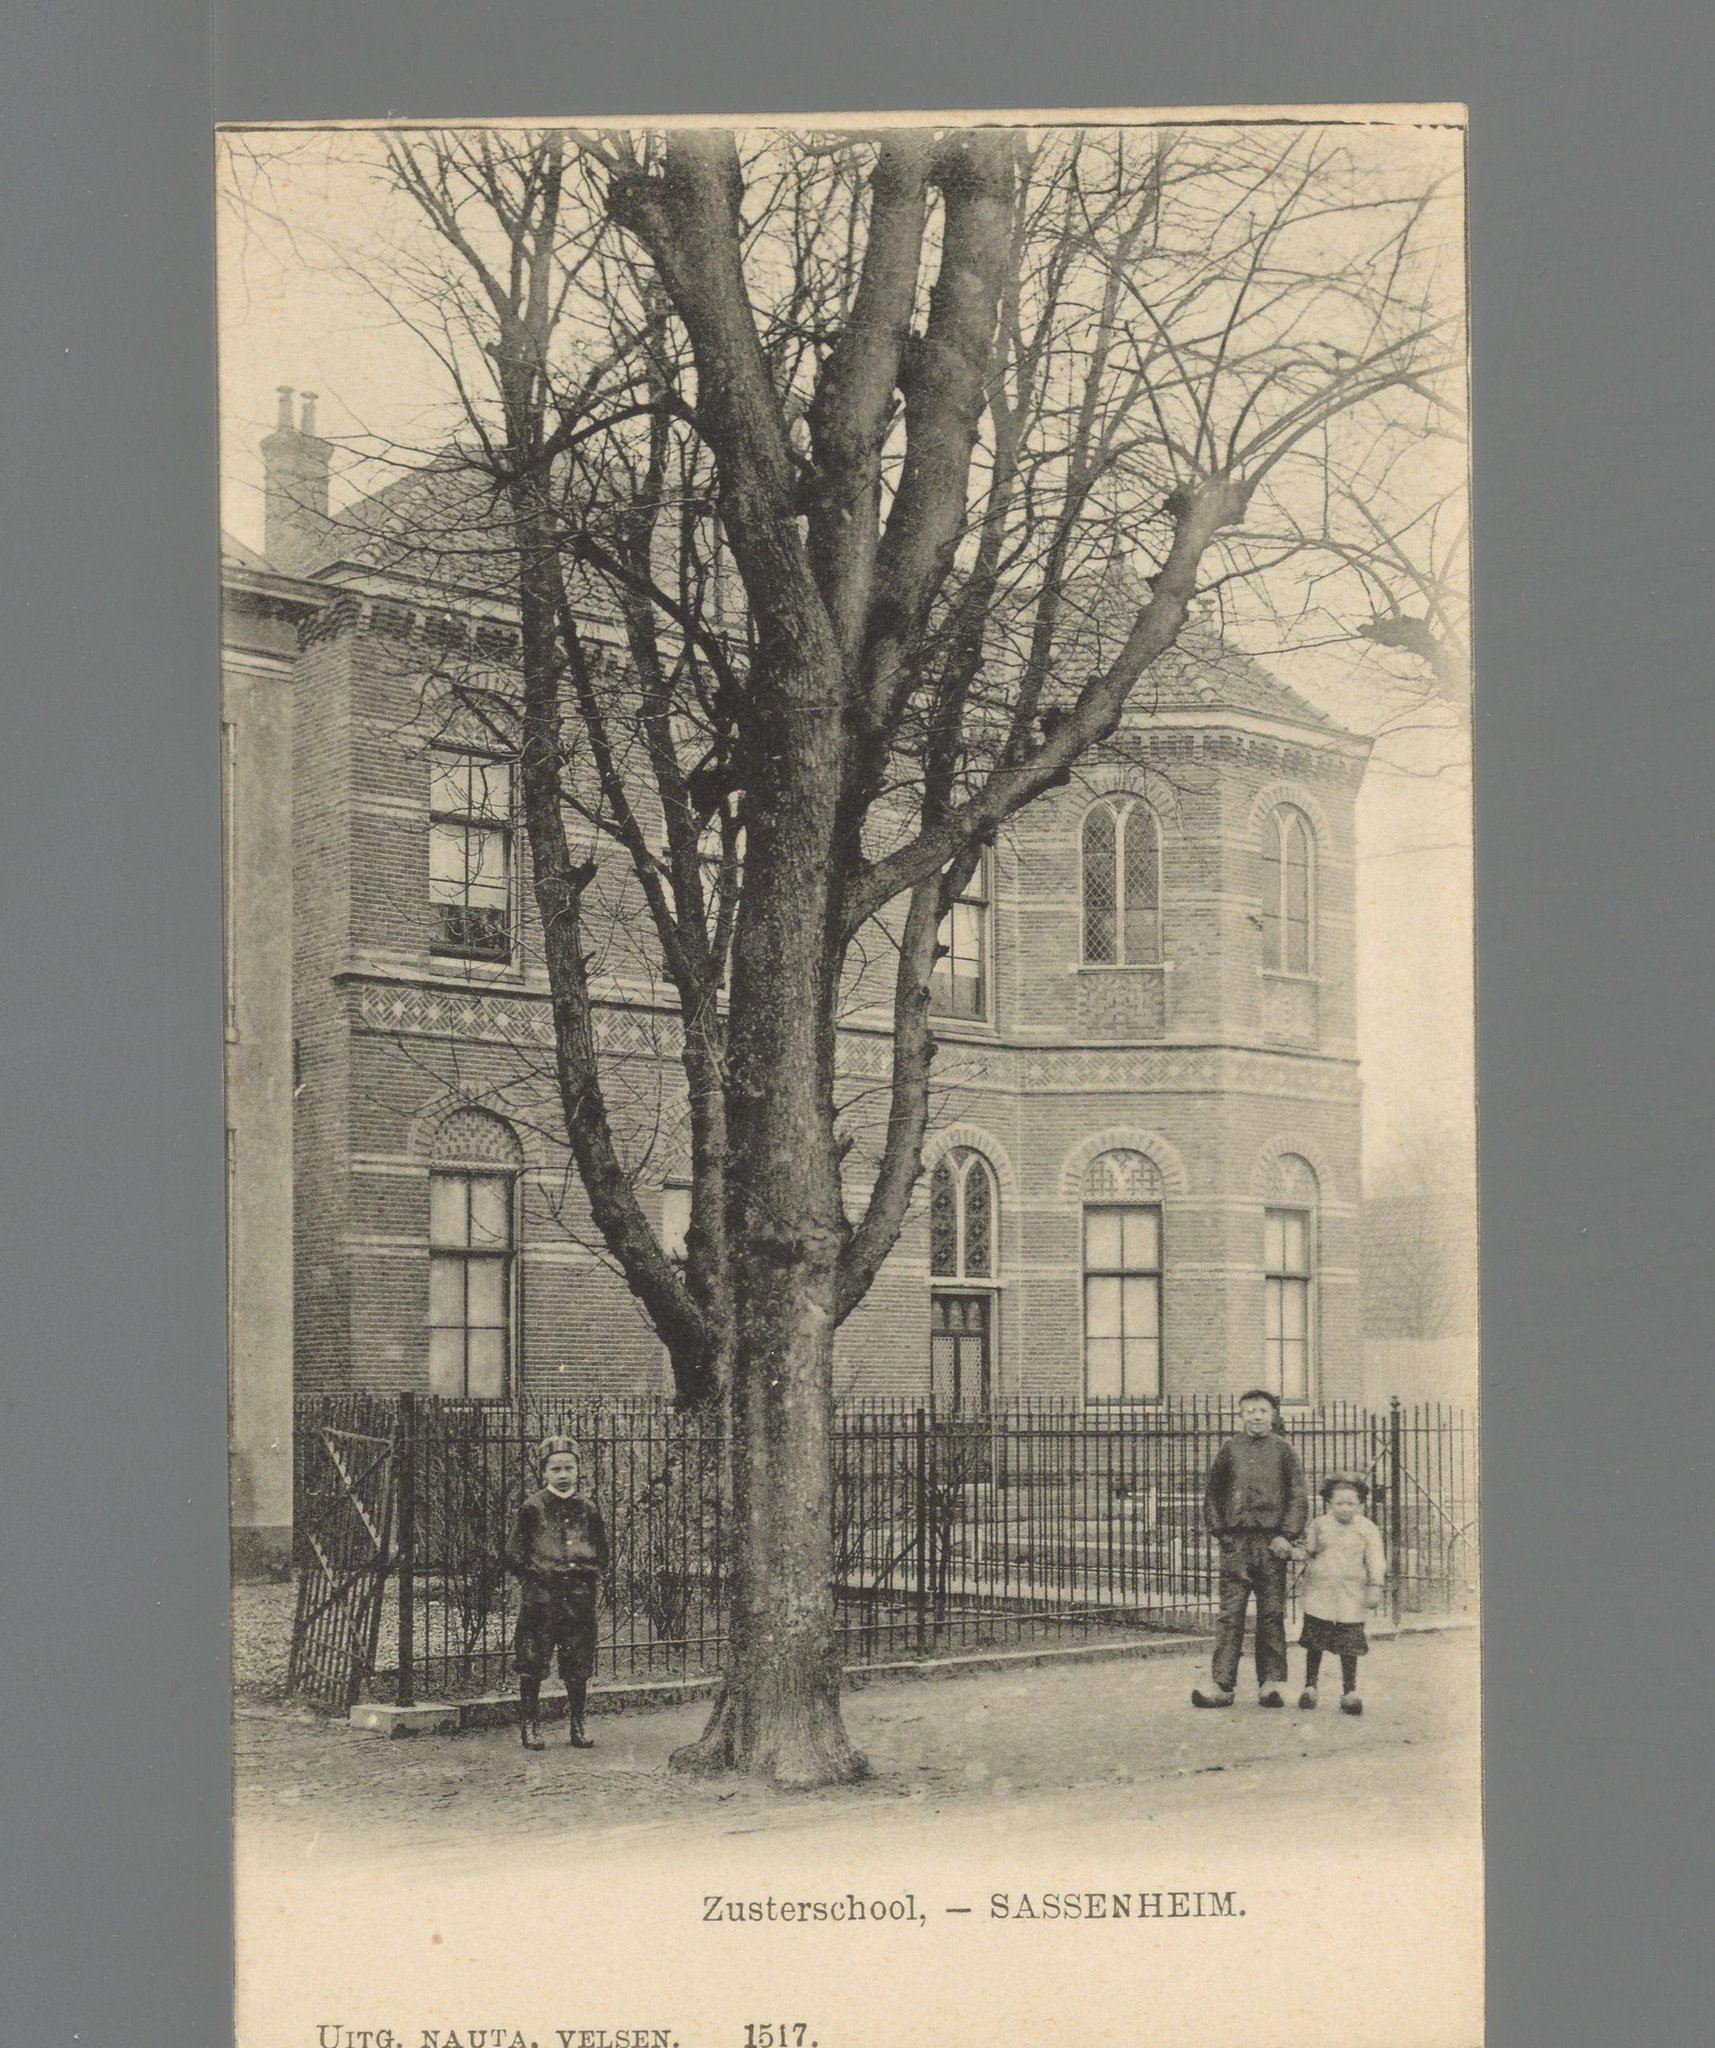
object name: ansichtkaart, prentbriefkaart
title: Zusterschool, - Sassenheim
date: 1897-1905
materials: cardboard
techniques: photograph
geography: sassenheim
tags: elementary school; class, form